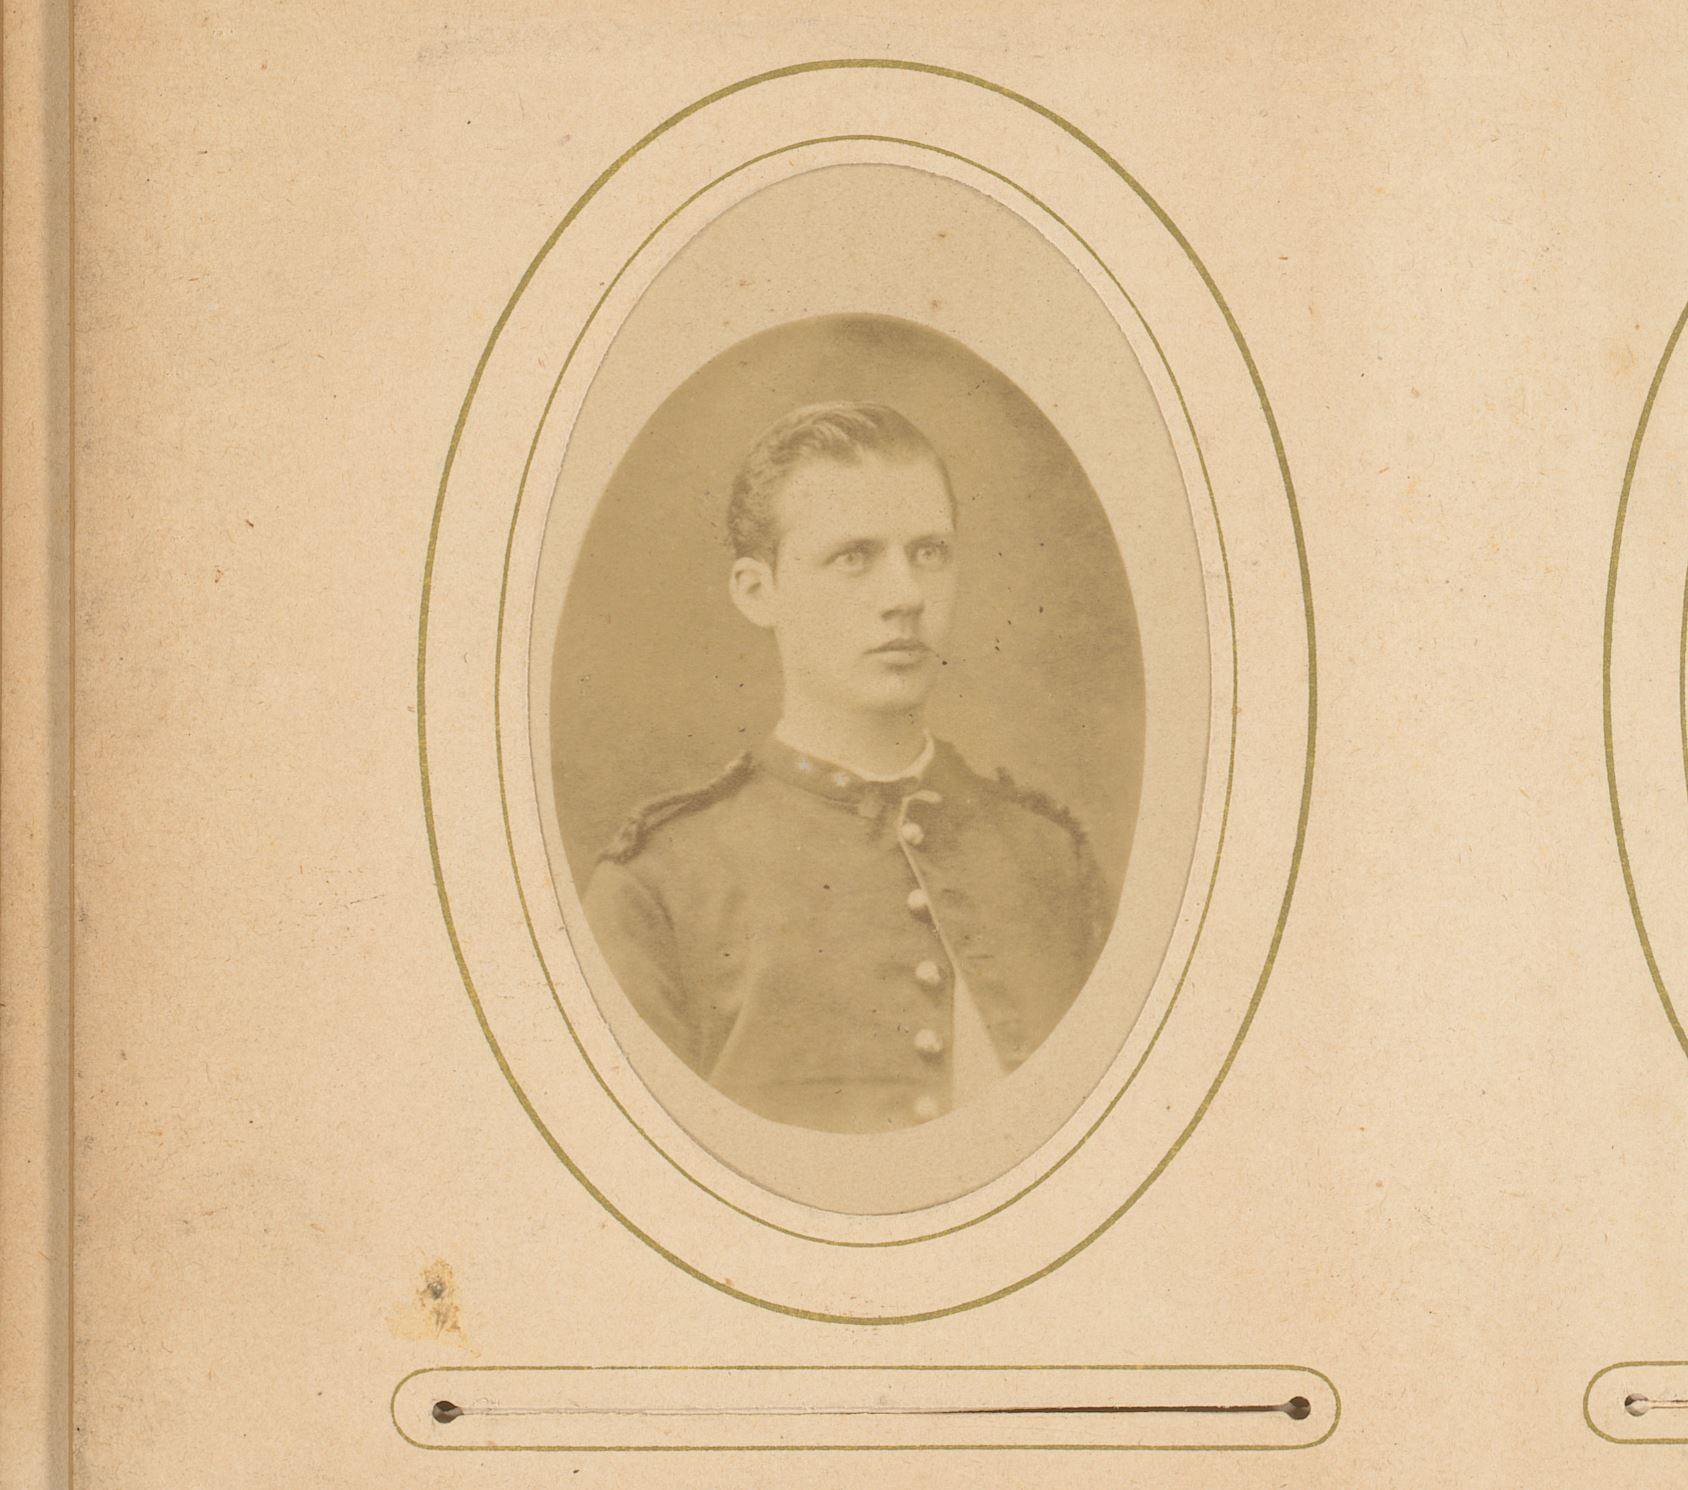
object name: photograph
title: Portret van een jonge man in uniform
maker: adolphe zimmermans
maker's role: fotograaf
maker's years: 1858-1922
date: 1879-1883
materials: cardboard, photographic support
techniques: albumen print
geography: the hague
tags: historical persons, youth, adolescent, (military) uniforms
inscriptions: inscription: ‘Adolphe Zimmermans/ Photographe/ Riemerstraat No 48/ La Haye.’